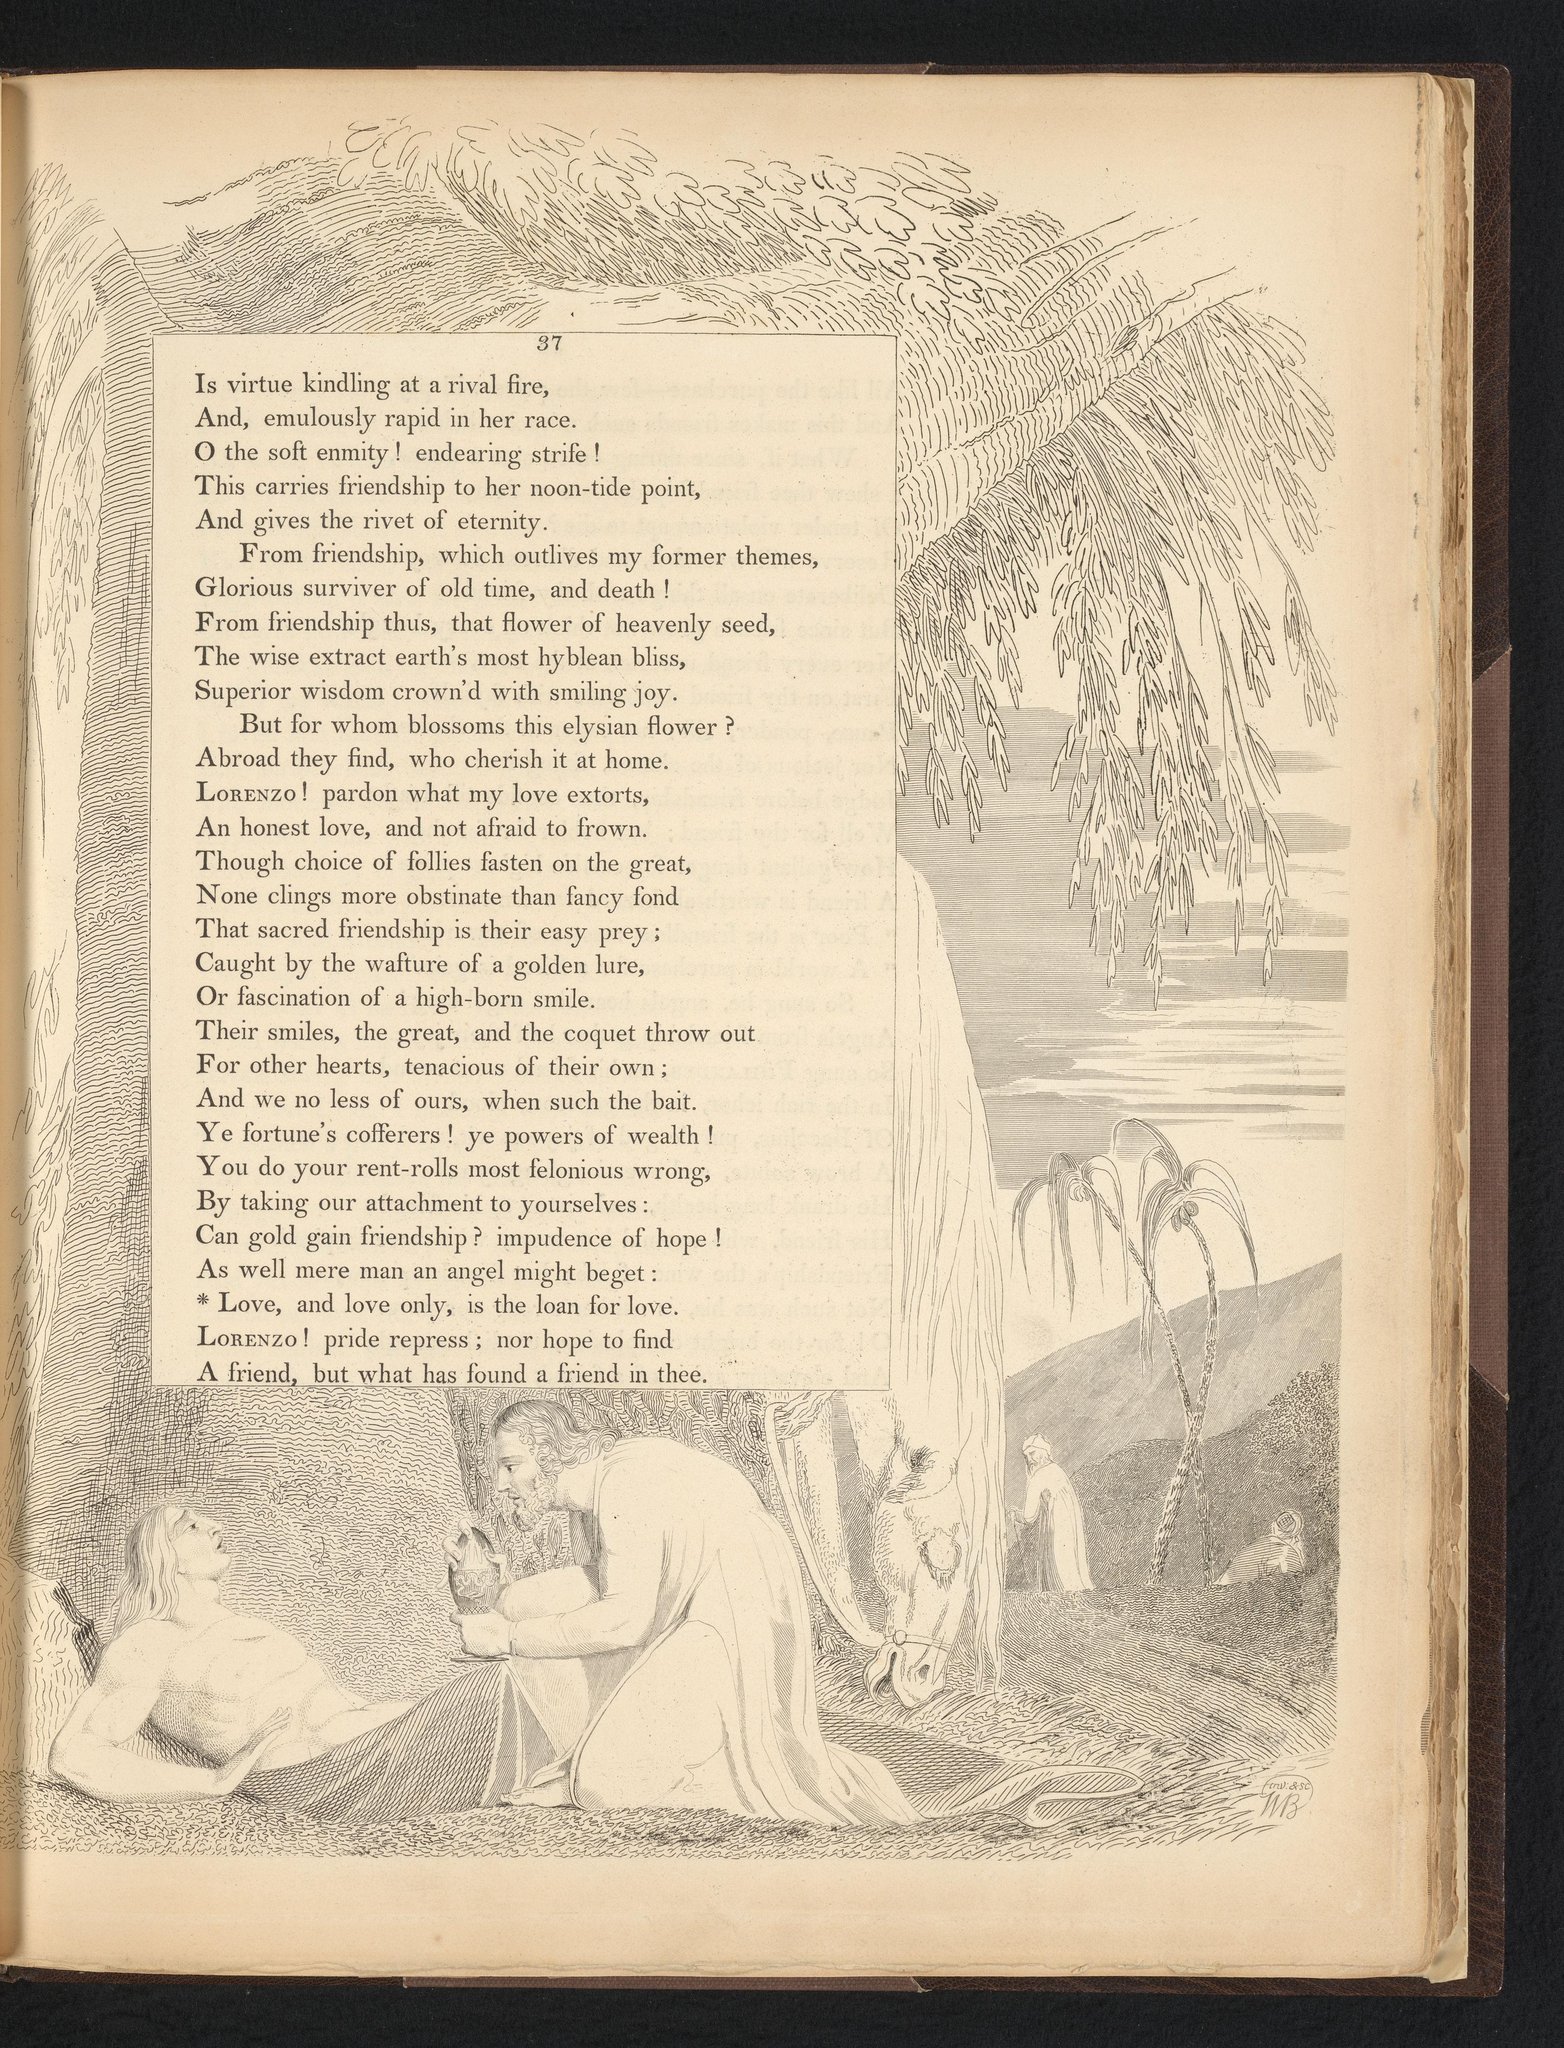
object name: page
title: Man hurkt bij een liggende man naast een boom met paard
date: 1796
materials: paper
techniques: engraving, letterpress printing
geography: london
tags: adult man, (traveller) resting in the open air, waking up, horse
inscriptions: : ‘Is virtue kindling at al rival fire, (...)’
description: Prent maakt deel uit van een boek, bladzijde 37. Tekst in het Engels op recto en verso.